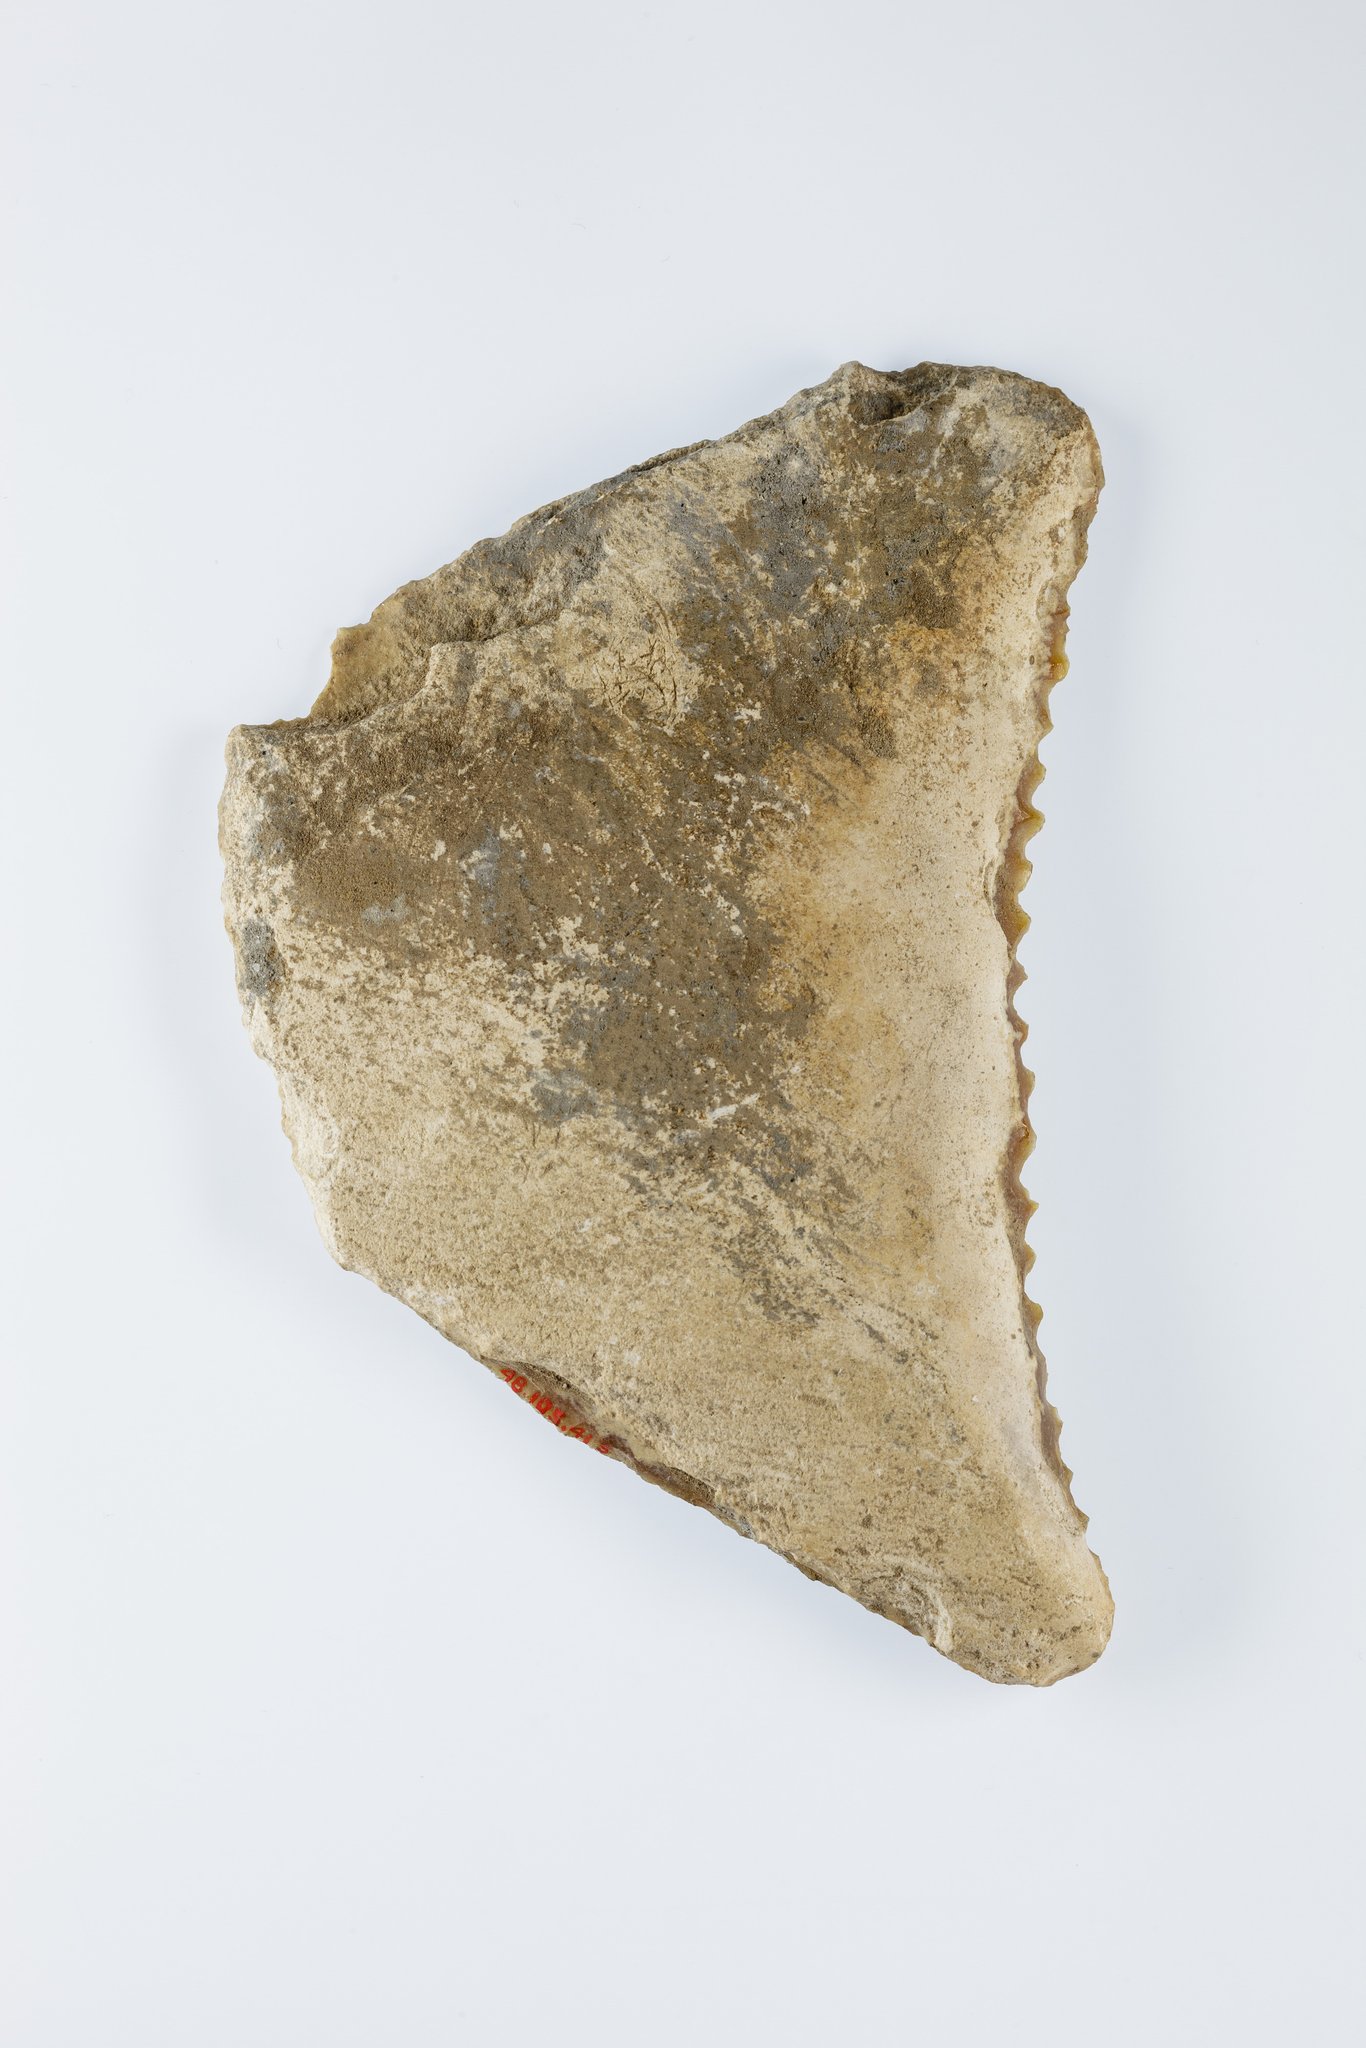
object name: sickle, denticulate, truncated, backed, geometric, tool, element, adhesive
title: Sickle Insert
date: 1184-664 BCE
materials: stone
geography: egypt